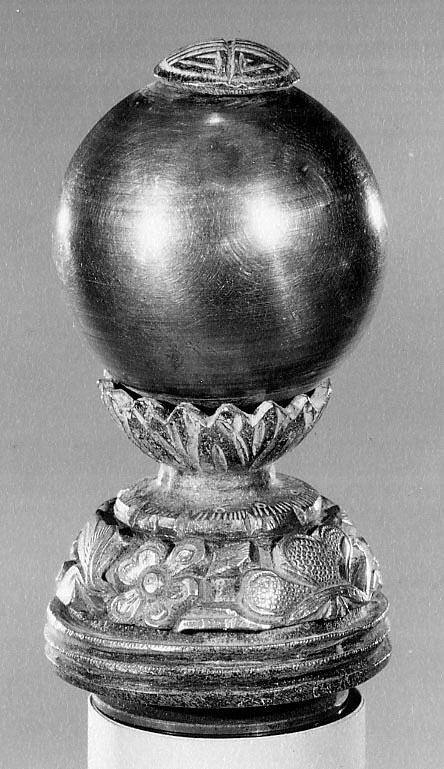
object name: hat finial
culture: chinese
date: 1901-1933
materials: brass